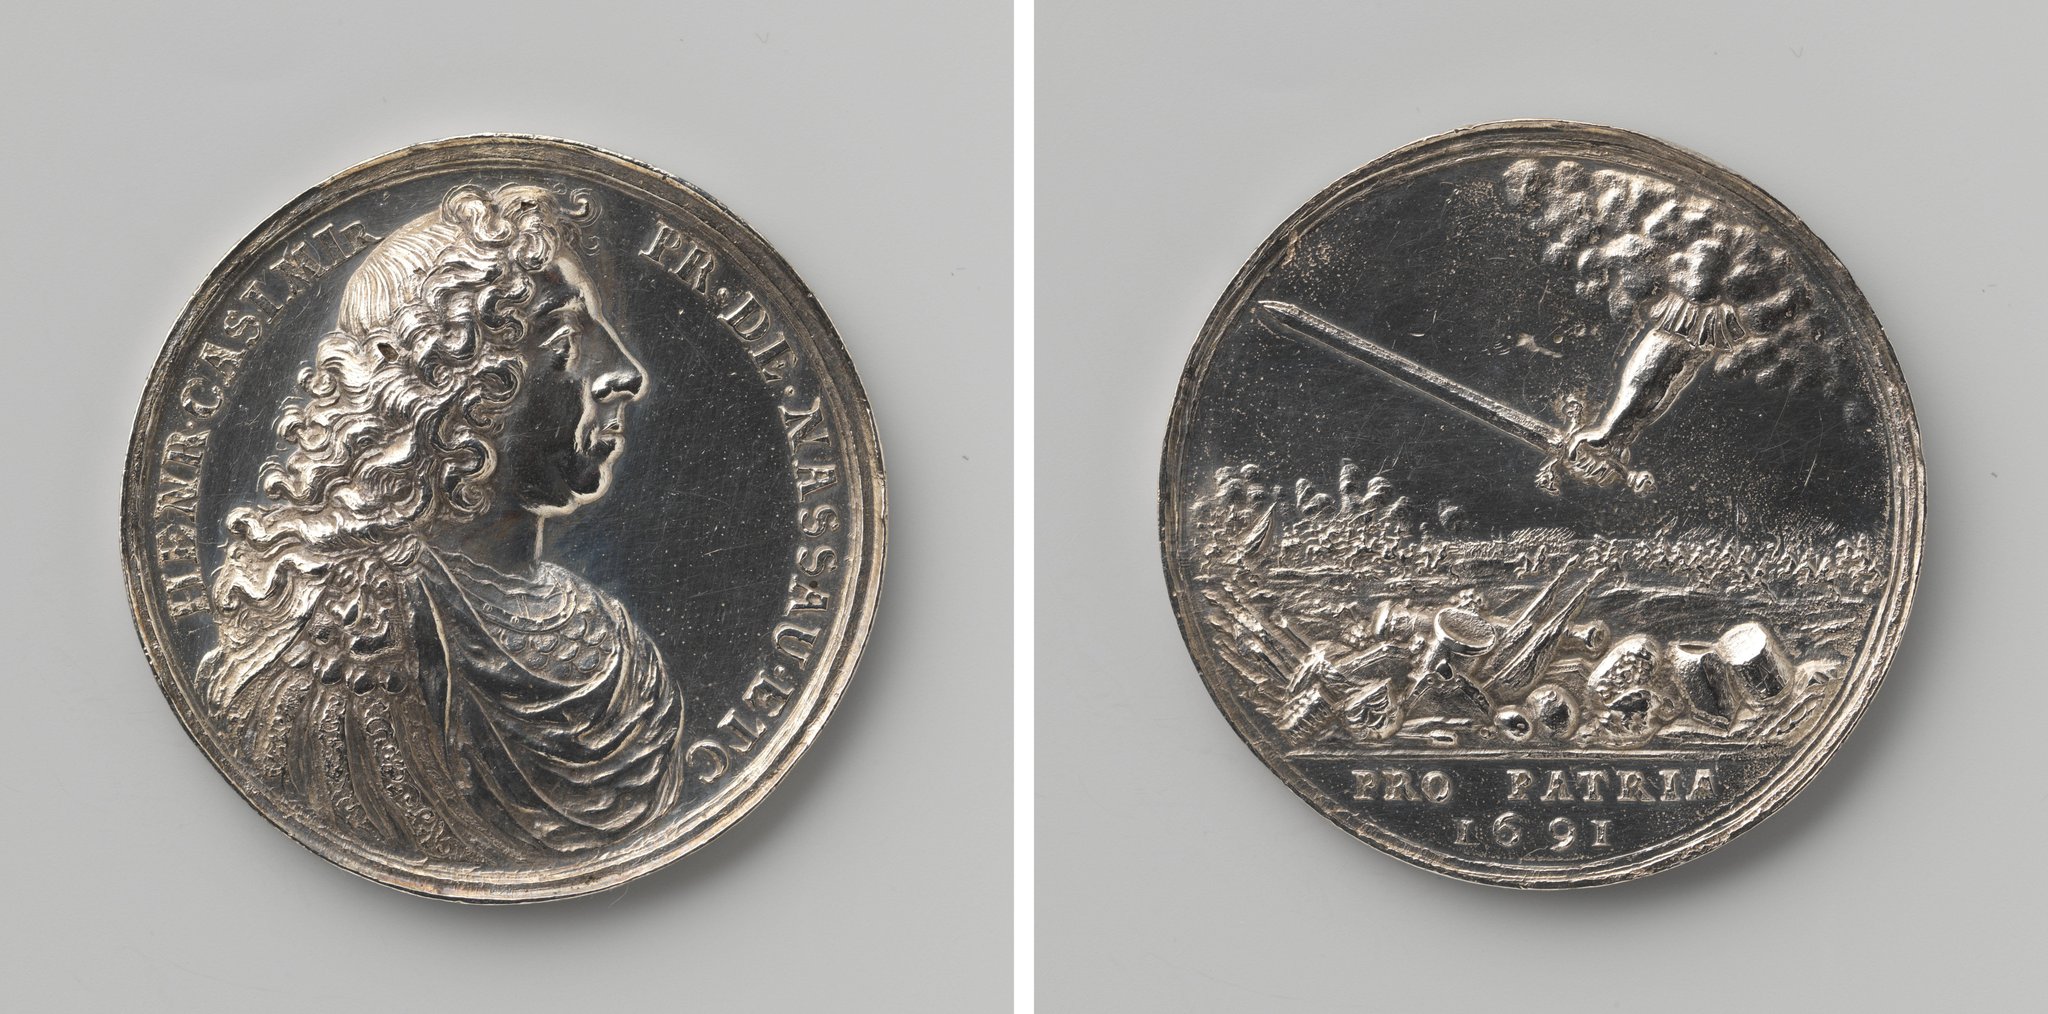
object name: history medal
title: Hendrik Casimir, erfstadhouder van Friesland en Groningen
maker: Anonymous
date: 1691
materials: silver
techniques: striking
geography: netherlands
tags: hendrik casimir ii graaf van nassau-dietz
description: Zilveren penning. Voorzijde: borststuk man binnen omschrift. Keerzijde: hand met zwaard uit wolken boven wapentuig, op achtergrond veldslag; afsnede: opschrift